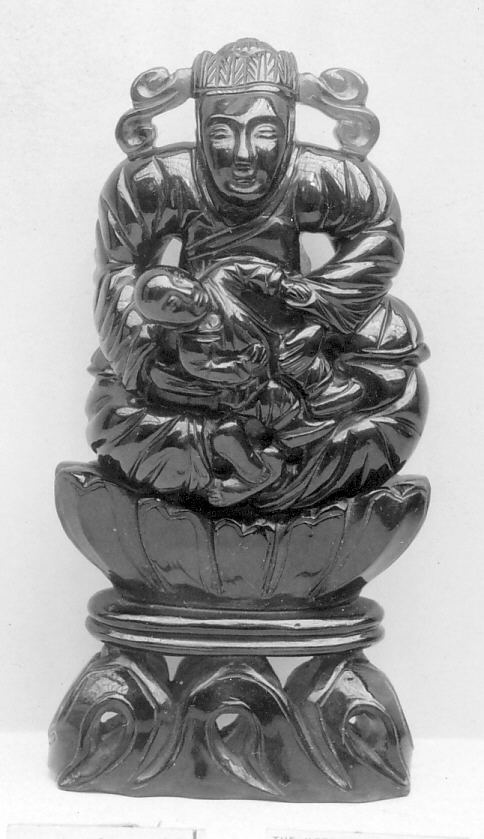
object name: figurine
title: Seated Figure Holding a Child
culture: chinese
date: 1801-1900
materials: amber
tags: human figures